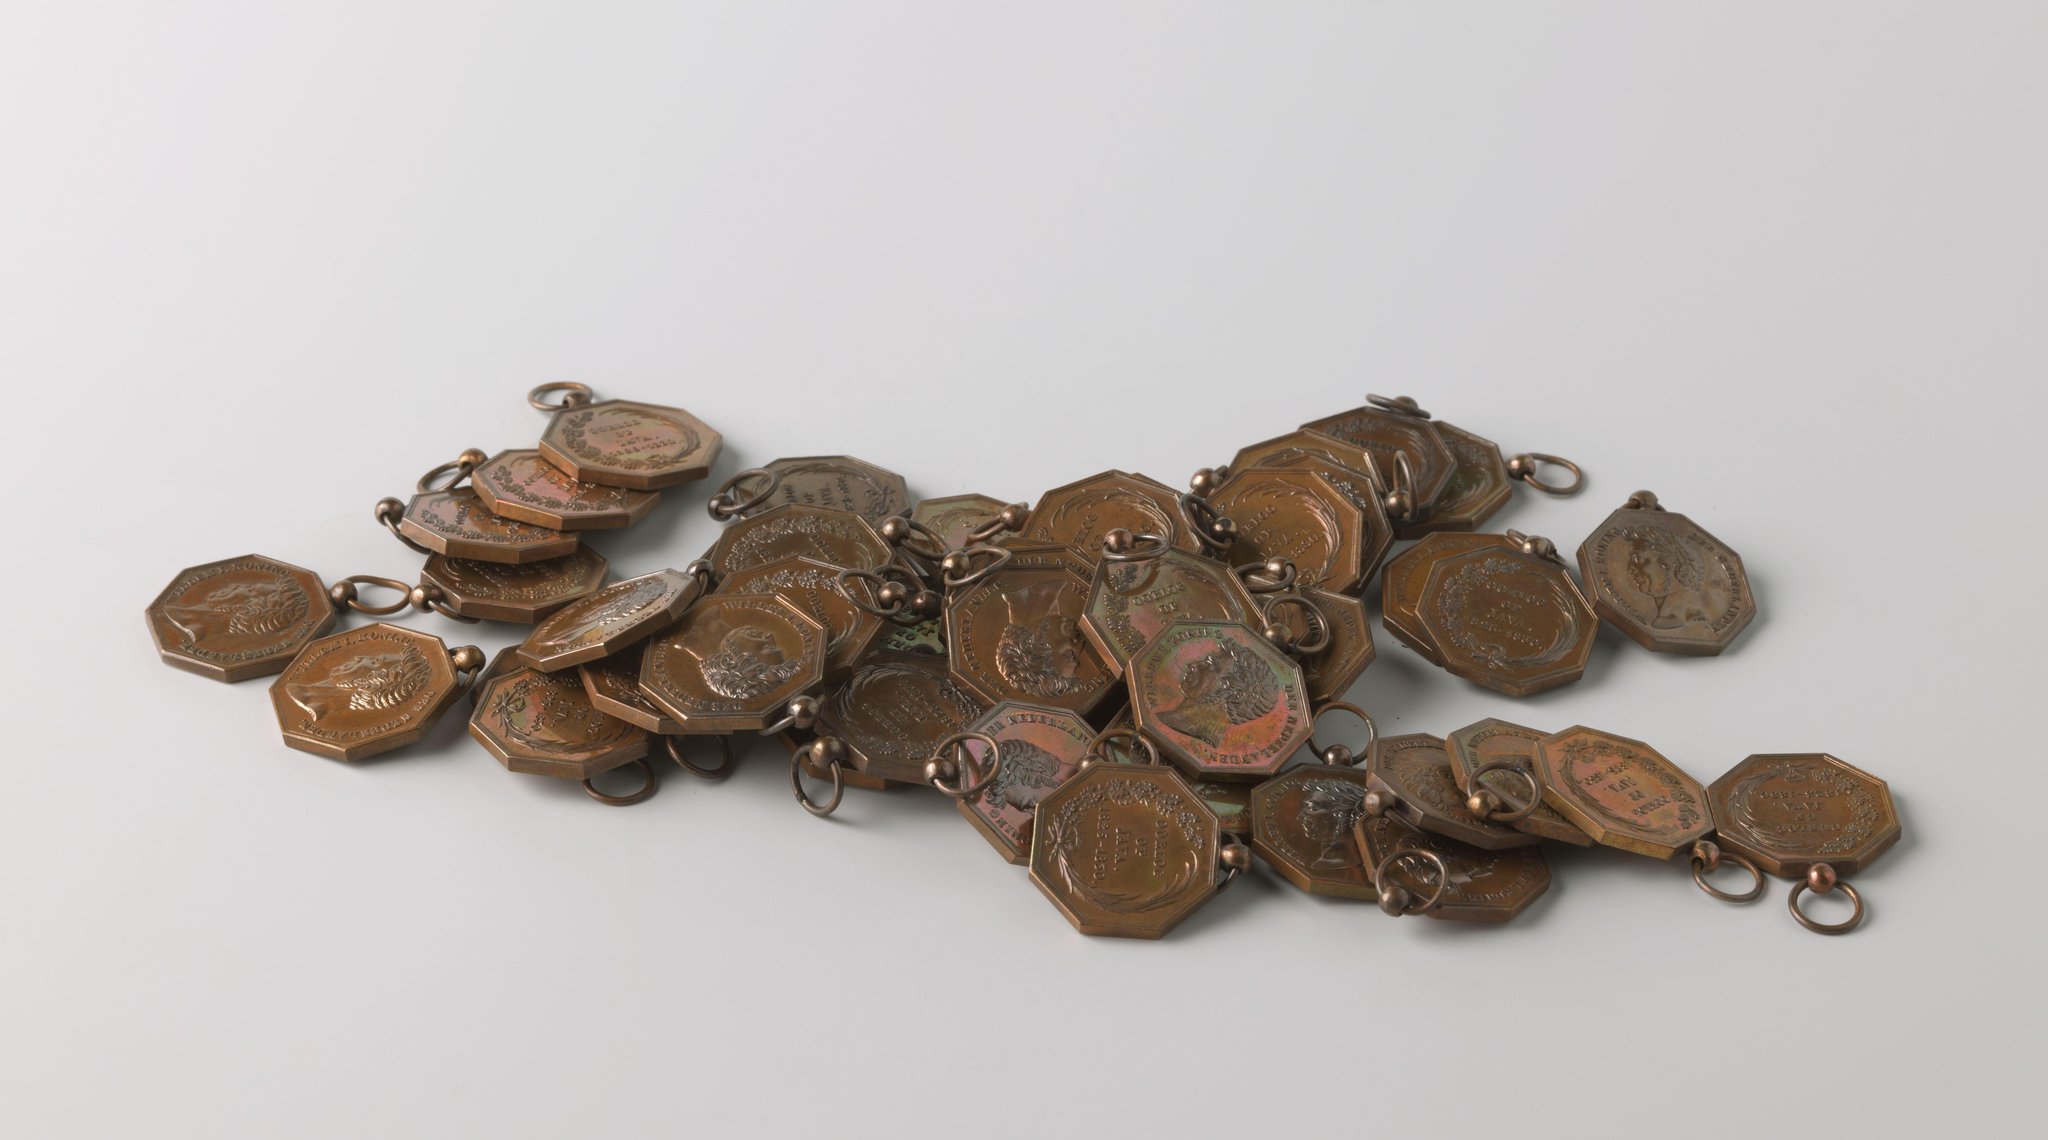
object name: insignia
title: Oorlog op Java, groot draagteken uitgereikt aan de deelnemers, ter ere van Willem I Frederik, koning der Nederlanden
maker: david van der kellen (1804-1879)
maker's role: die cutter, draughtsman, print maker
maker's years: 1804-1879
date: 1830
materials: bronze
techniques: striking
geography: utrecht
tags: the hague, berlin, william i of the netherlands, java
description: Achthoekig draagteken aan draagoog en draagring. Voorzijde: borststuk man binnen omschrift. Keerzijde: opschrift binnen tot krans samengebonden palm- en eiketak; twee aan draaglint.